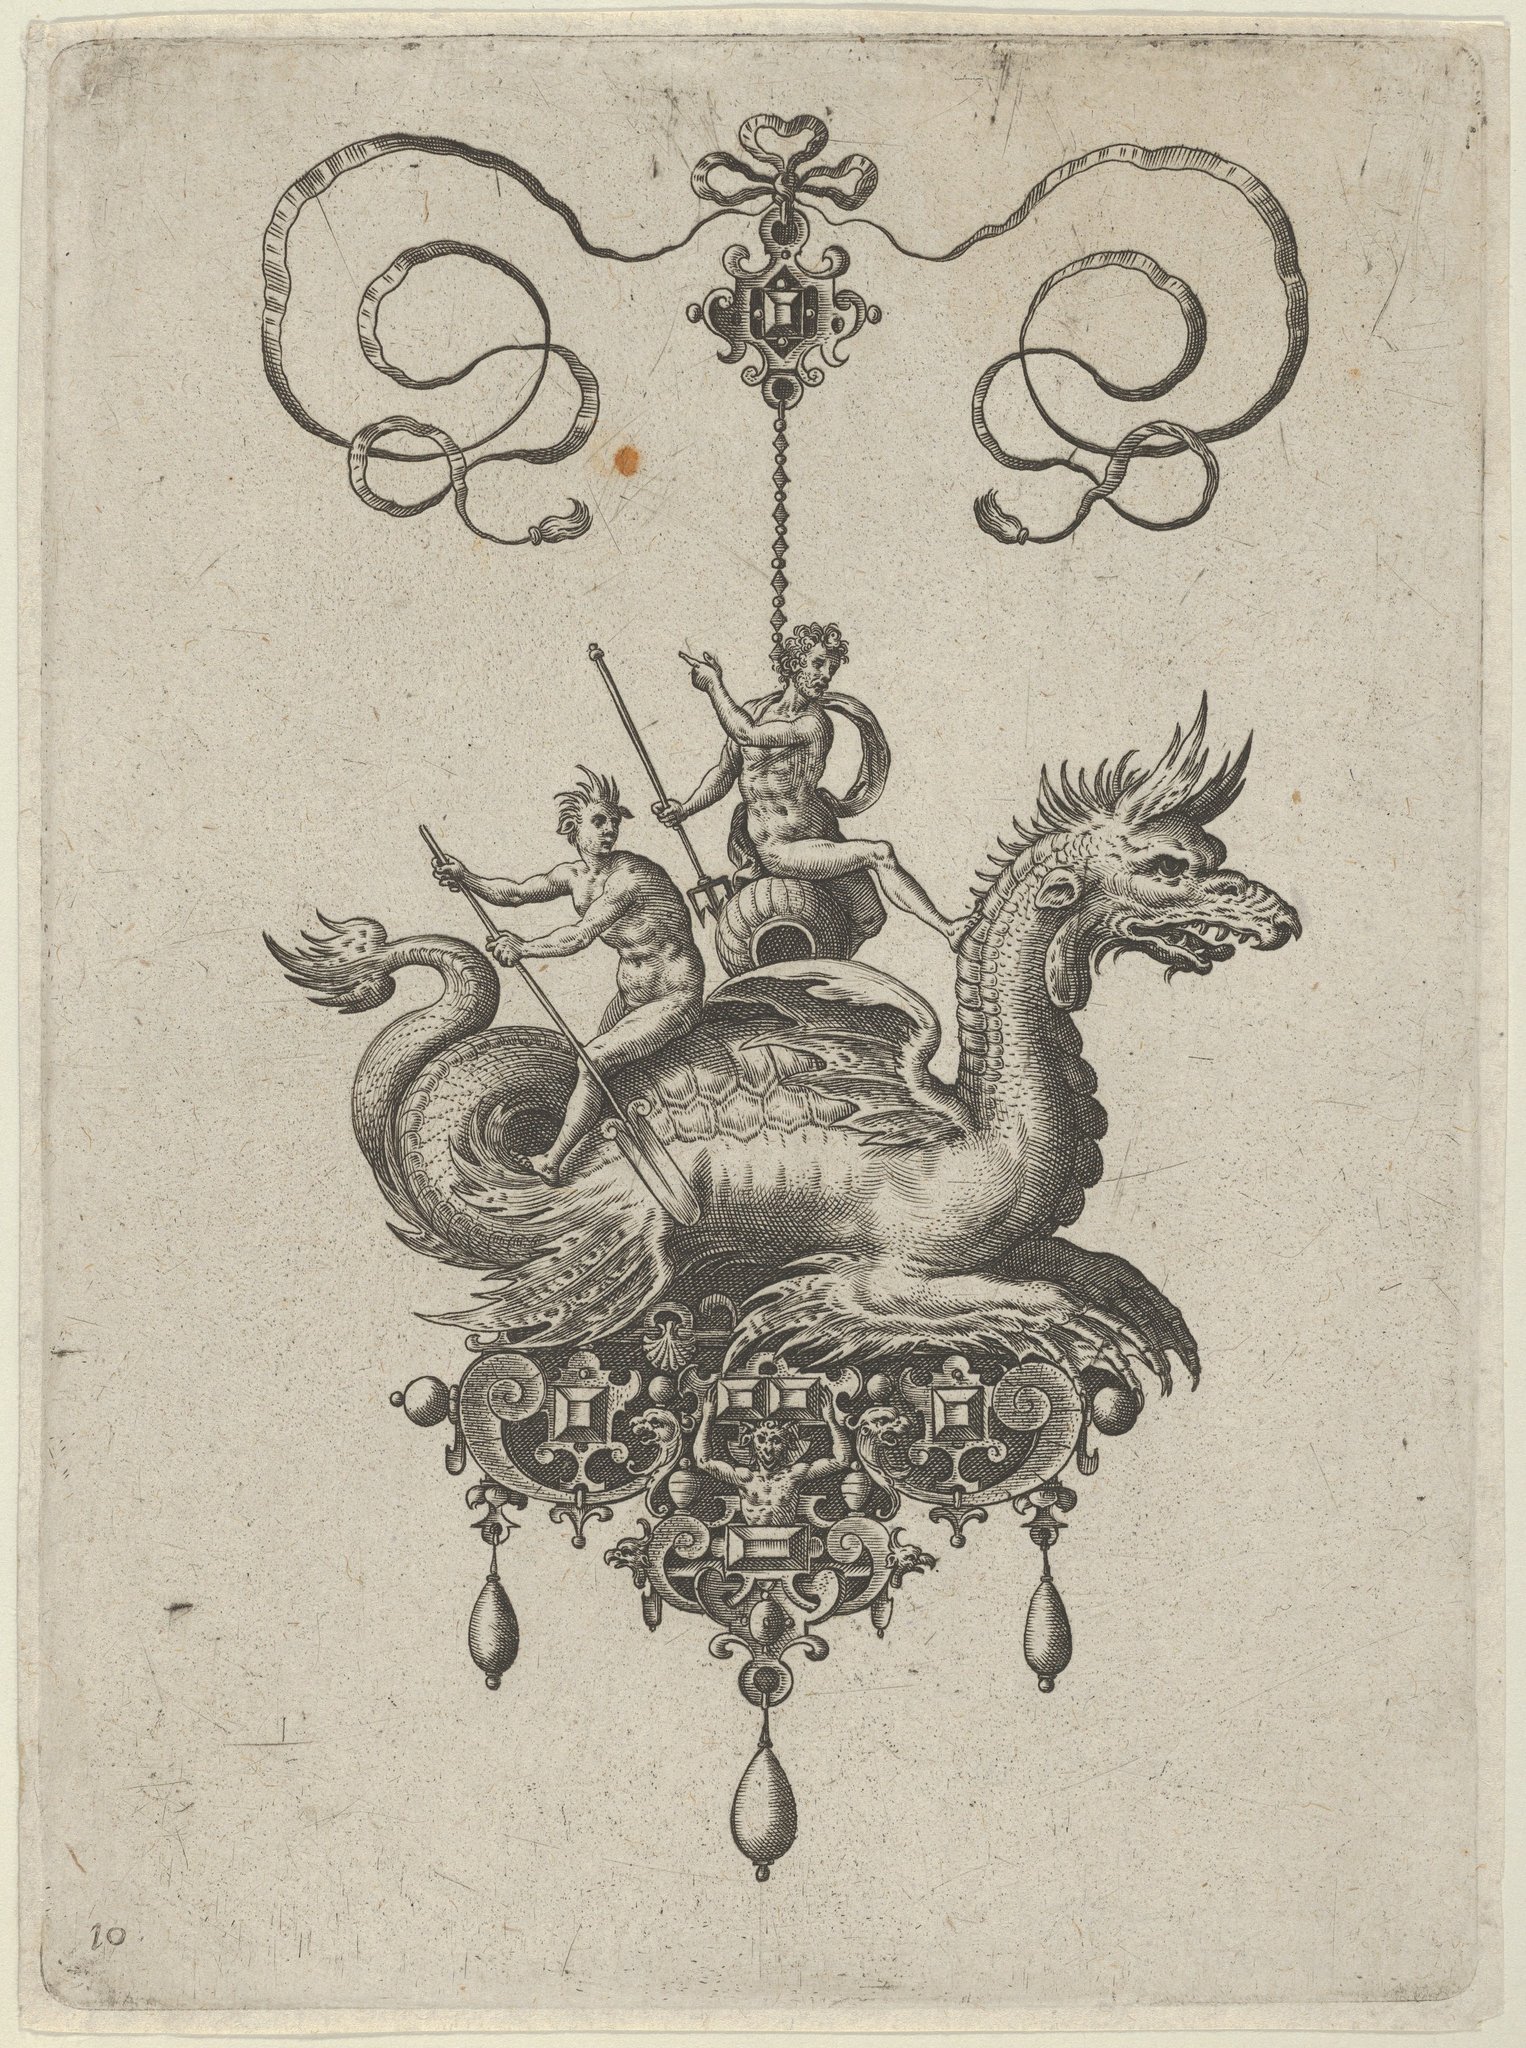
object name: print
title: Pendant Design with a Sea Monster Carrying Neptune on an Urn Beside a River-God with an Oar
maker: adriaen collaert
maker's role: artist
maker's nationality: netherlandish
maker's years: 1560-1618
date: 1582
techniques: engraving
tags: pendants,monsters,neptune